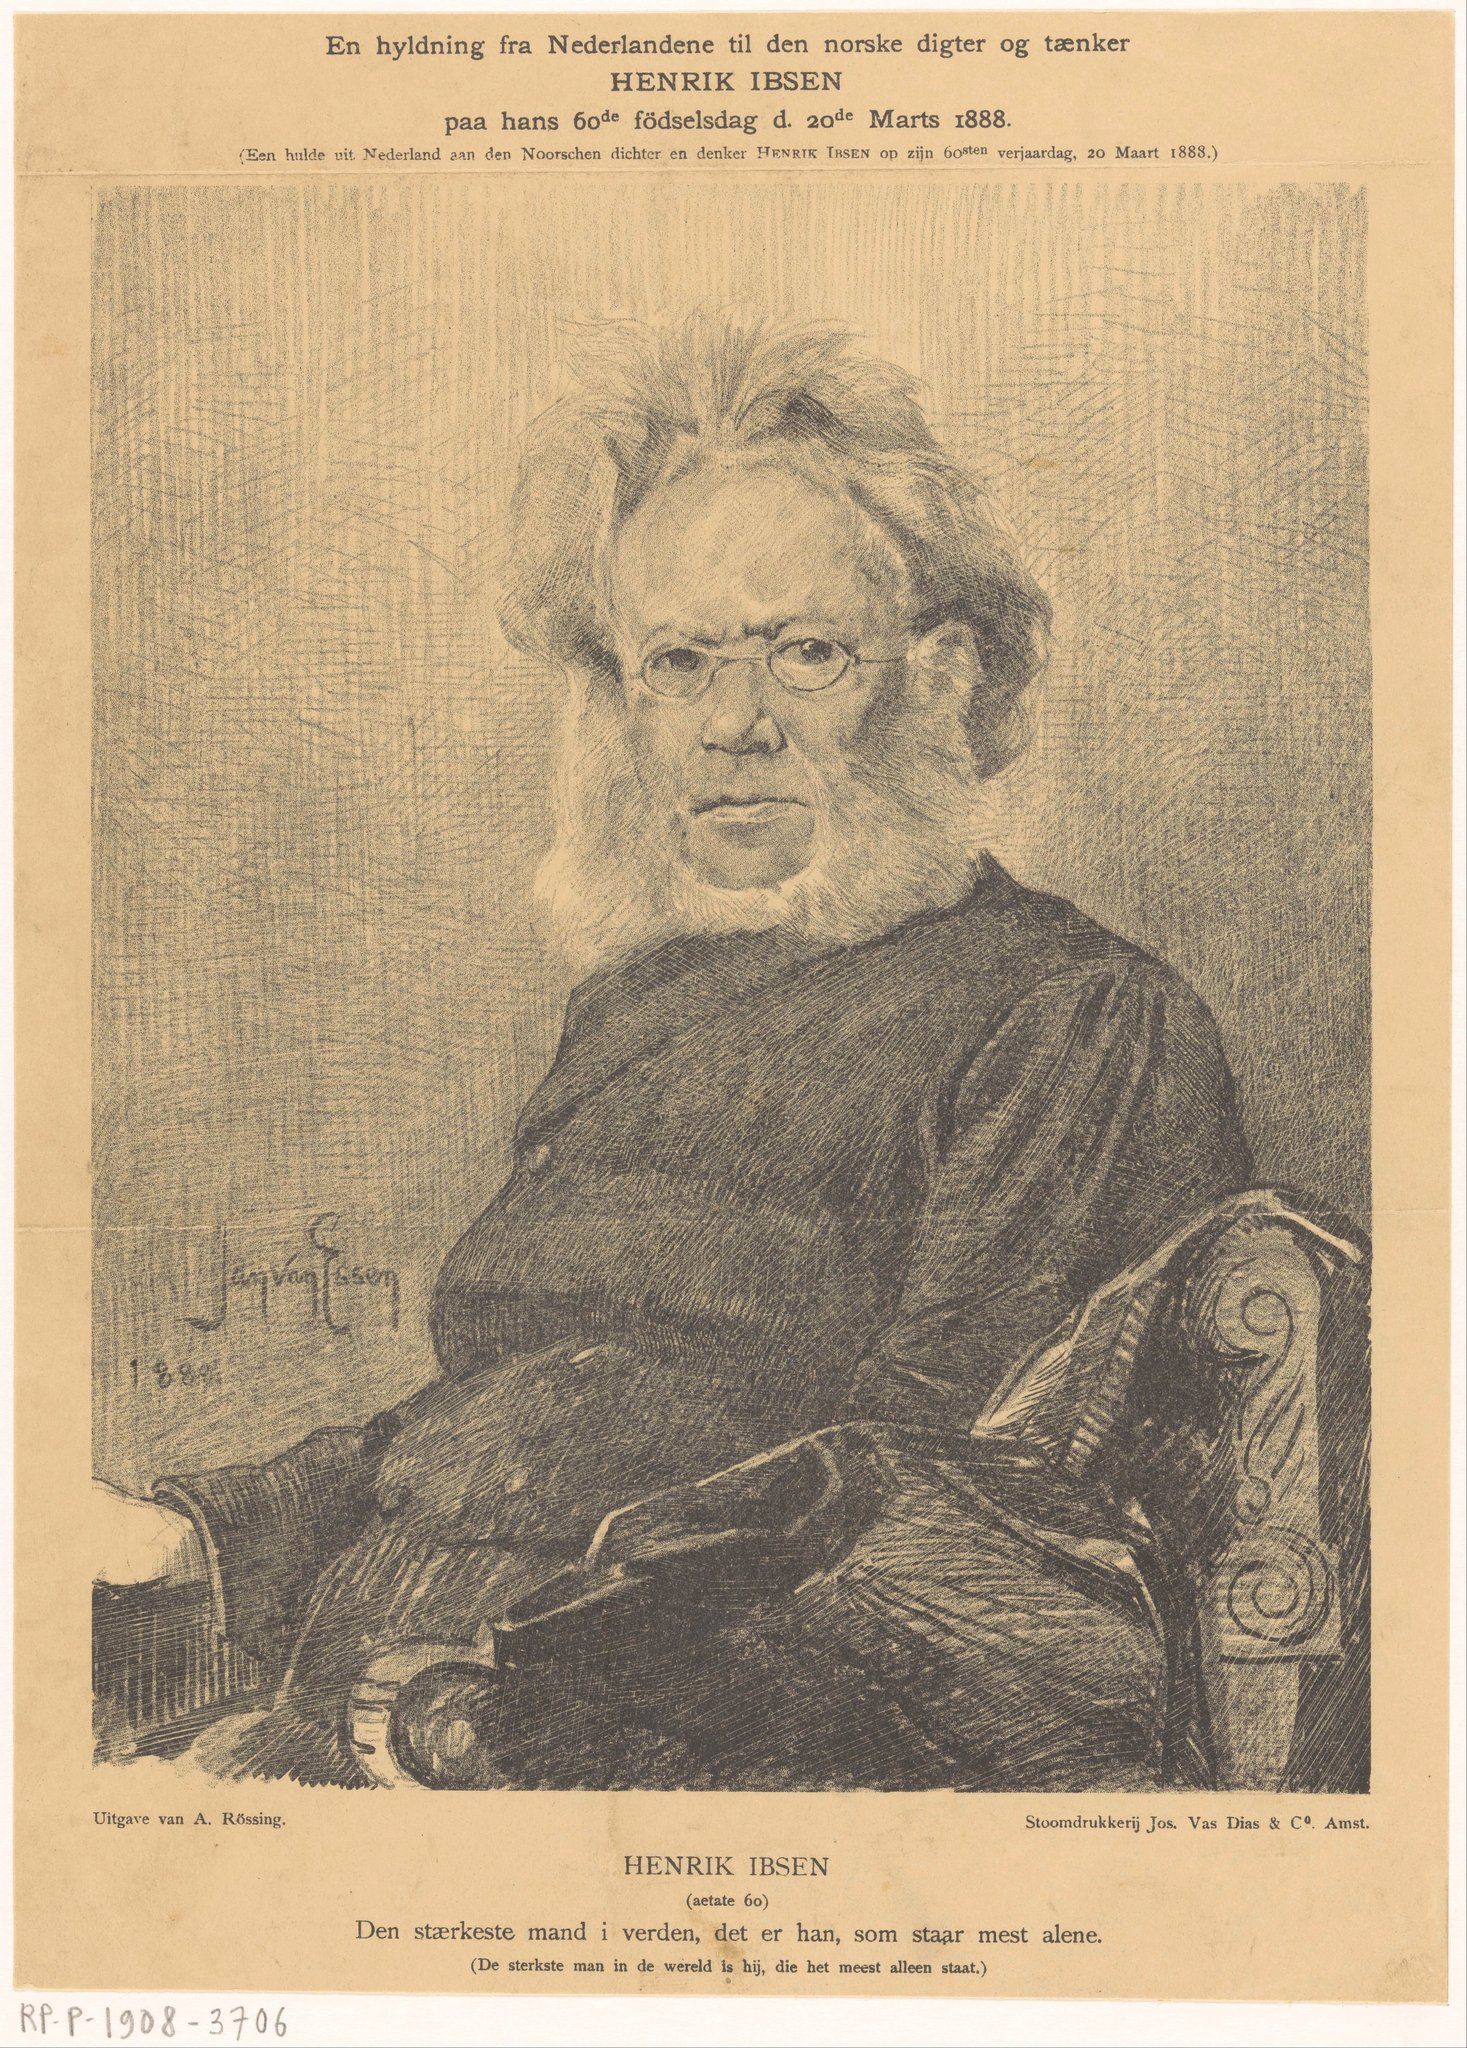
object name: print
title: Portret van Henrik Ibsen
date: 1888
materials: paper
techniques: lithograph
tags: portrait of a writer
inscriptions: collector's mark: Lugt 2228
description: Verschenen in het tijdschrift 'De Lantaarn', jaargang 4 (1888), nummer 6.